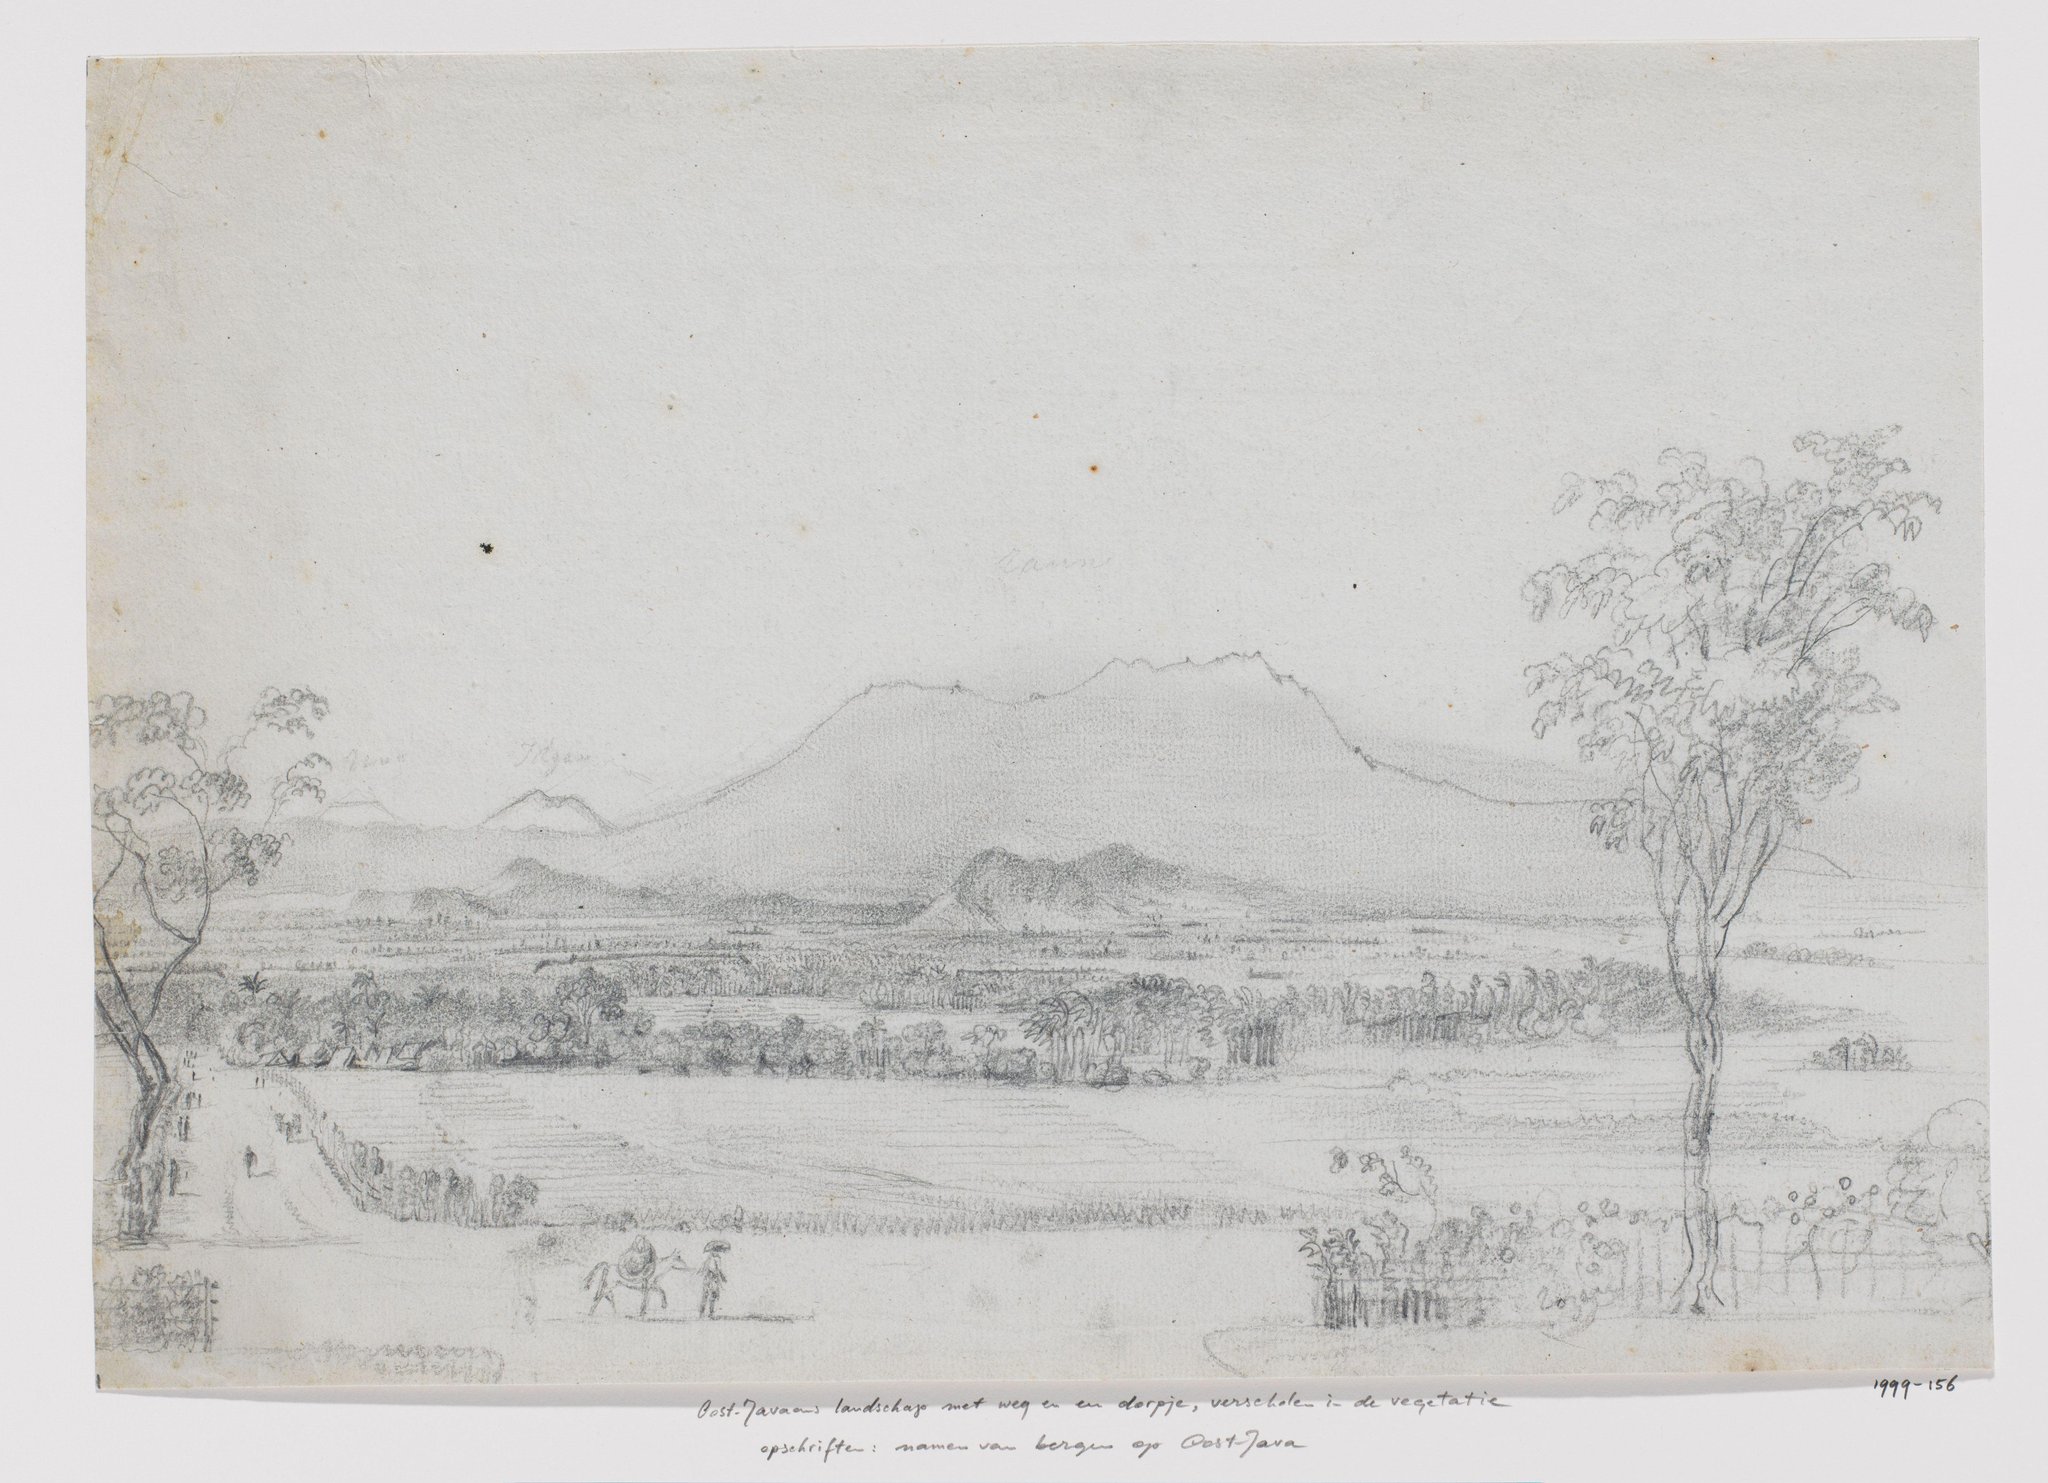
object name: drawing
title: Oost-Javaans landschap met weg, dorpje verscholen in vegetatie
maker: adrianus johannes bik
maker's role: draughtsman, print maker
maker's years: 1790-1872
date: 1821-1822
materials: chalk, paper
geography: east java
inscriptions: inscription: ‘Rané / Idjen / Raun’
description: artikel over deze collectie in Bulletin van het Rijksmuseum 49 [2001], nr. 4, pp.343 e.v.; Vriese 1858, p. 613